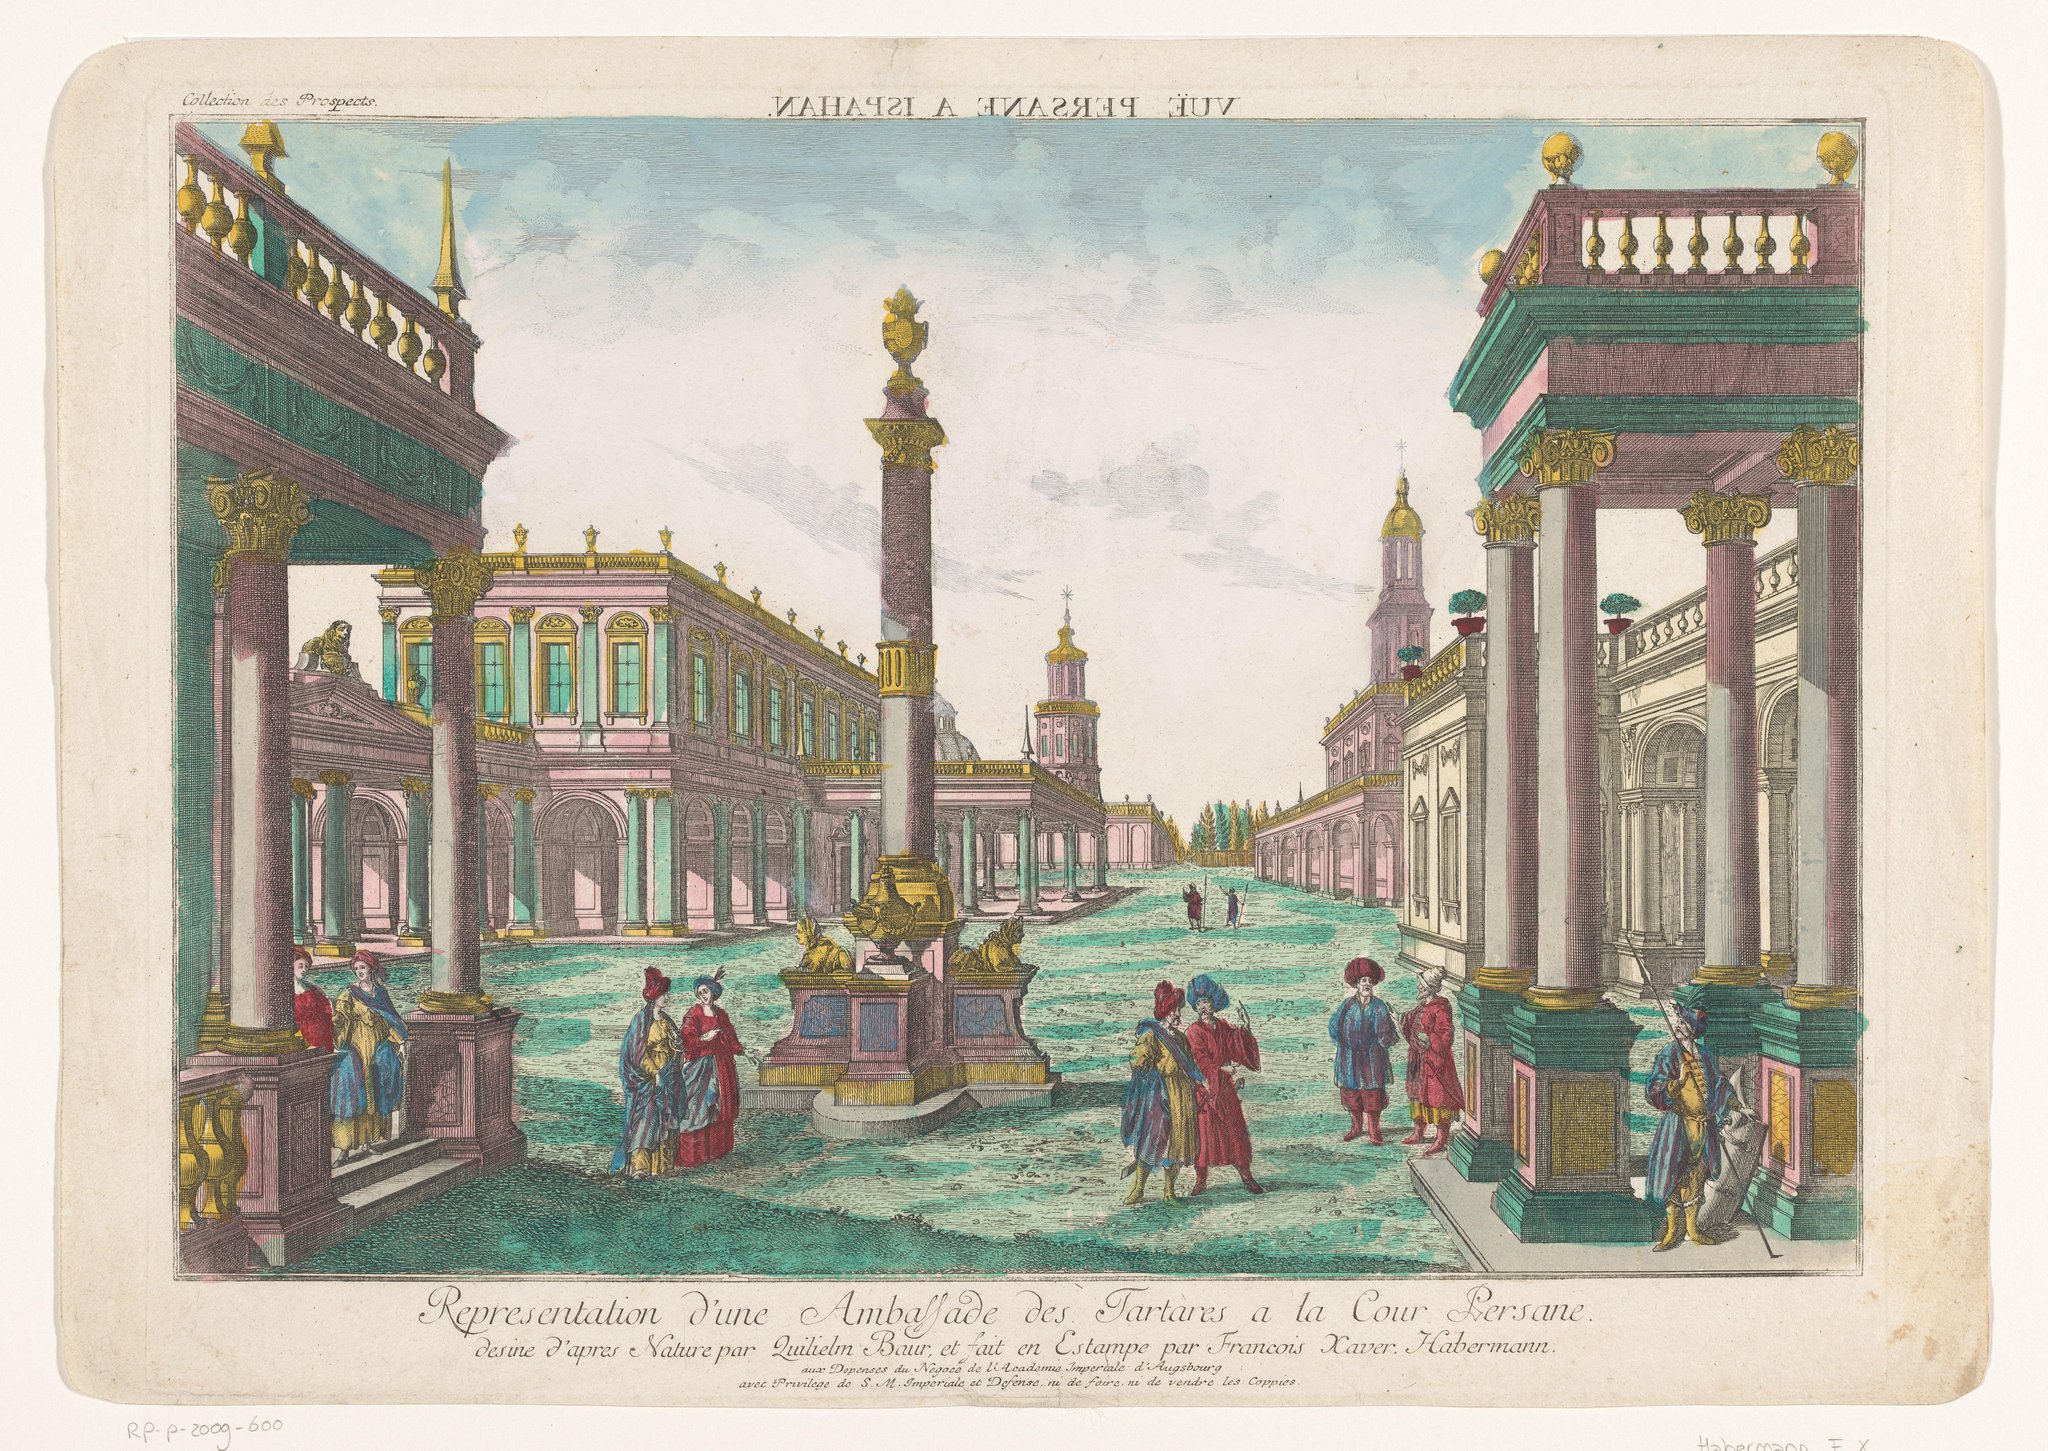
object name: opticaprent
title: Vuë Persane a Ispahan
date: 1755-1779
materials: paper, watercolor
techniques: brush, etching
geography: augsburg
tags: obelisk, needle (+ city(-scape) with figures, staffage), square, place, circus, etc. (+ city(-scape) with figures, staffage)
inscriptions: collector's mark: Lugt 2228, watermark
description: Gezicht op een groot plein met een obellisk in het midden en gebouwen met arcaden er omheen. oosters geklede figuren Enkele wandelende paren.